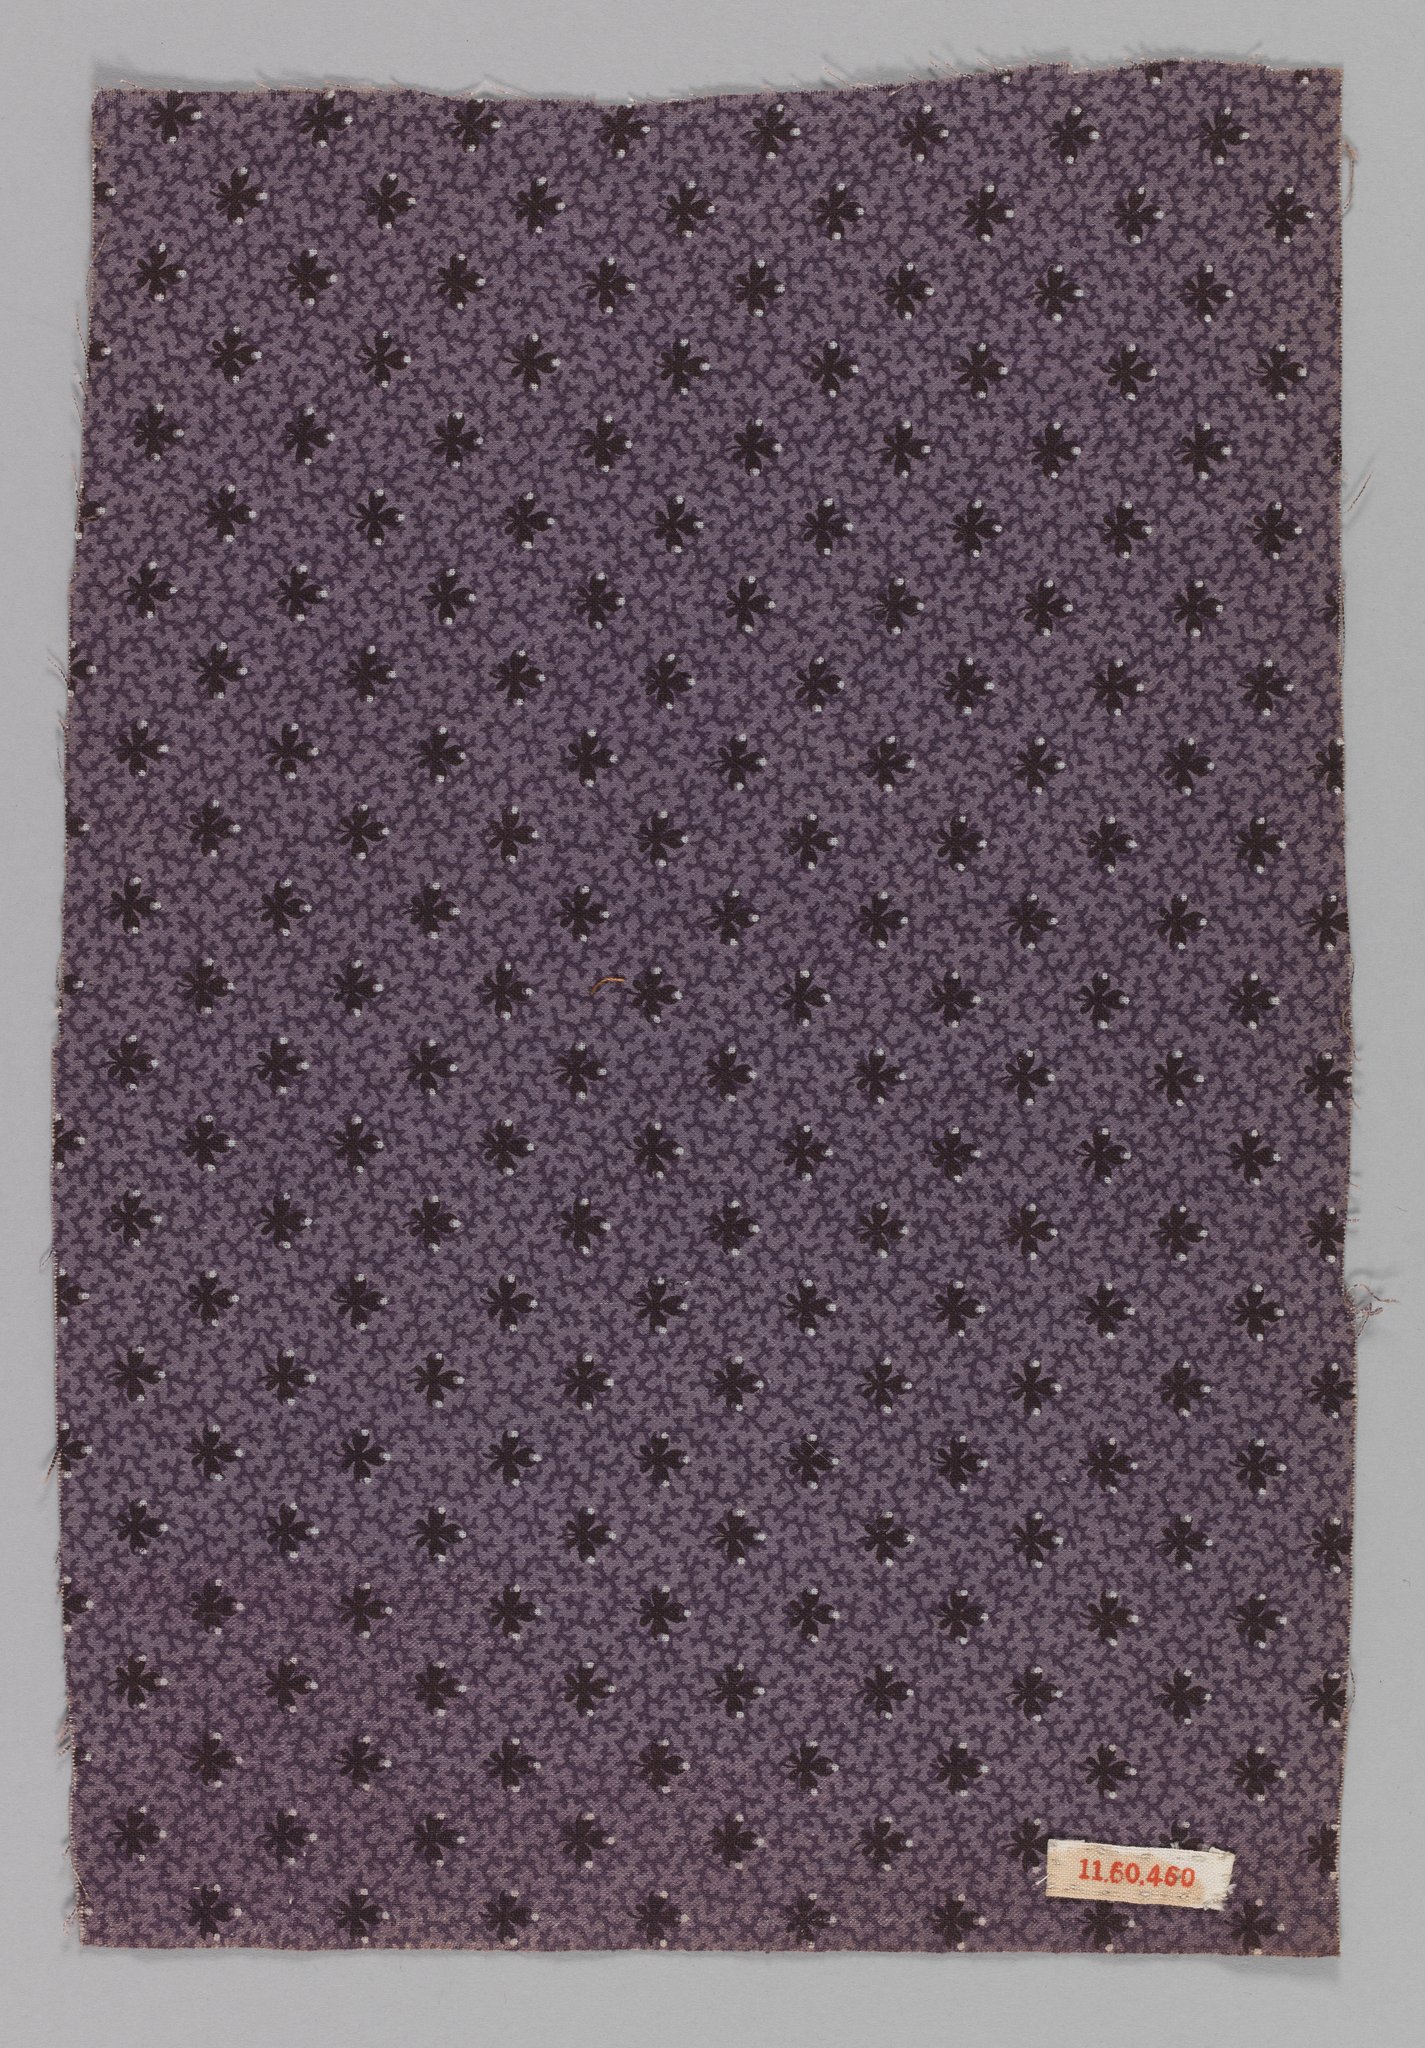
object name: piece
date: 1801-1900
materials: cotton